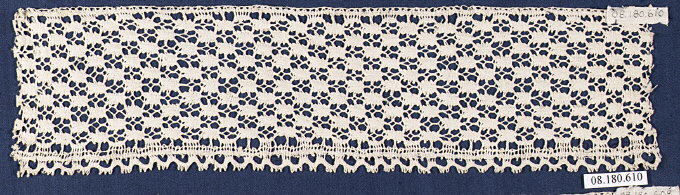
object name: fragment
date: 1701-1800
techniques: lace